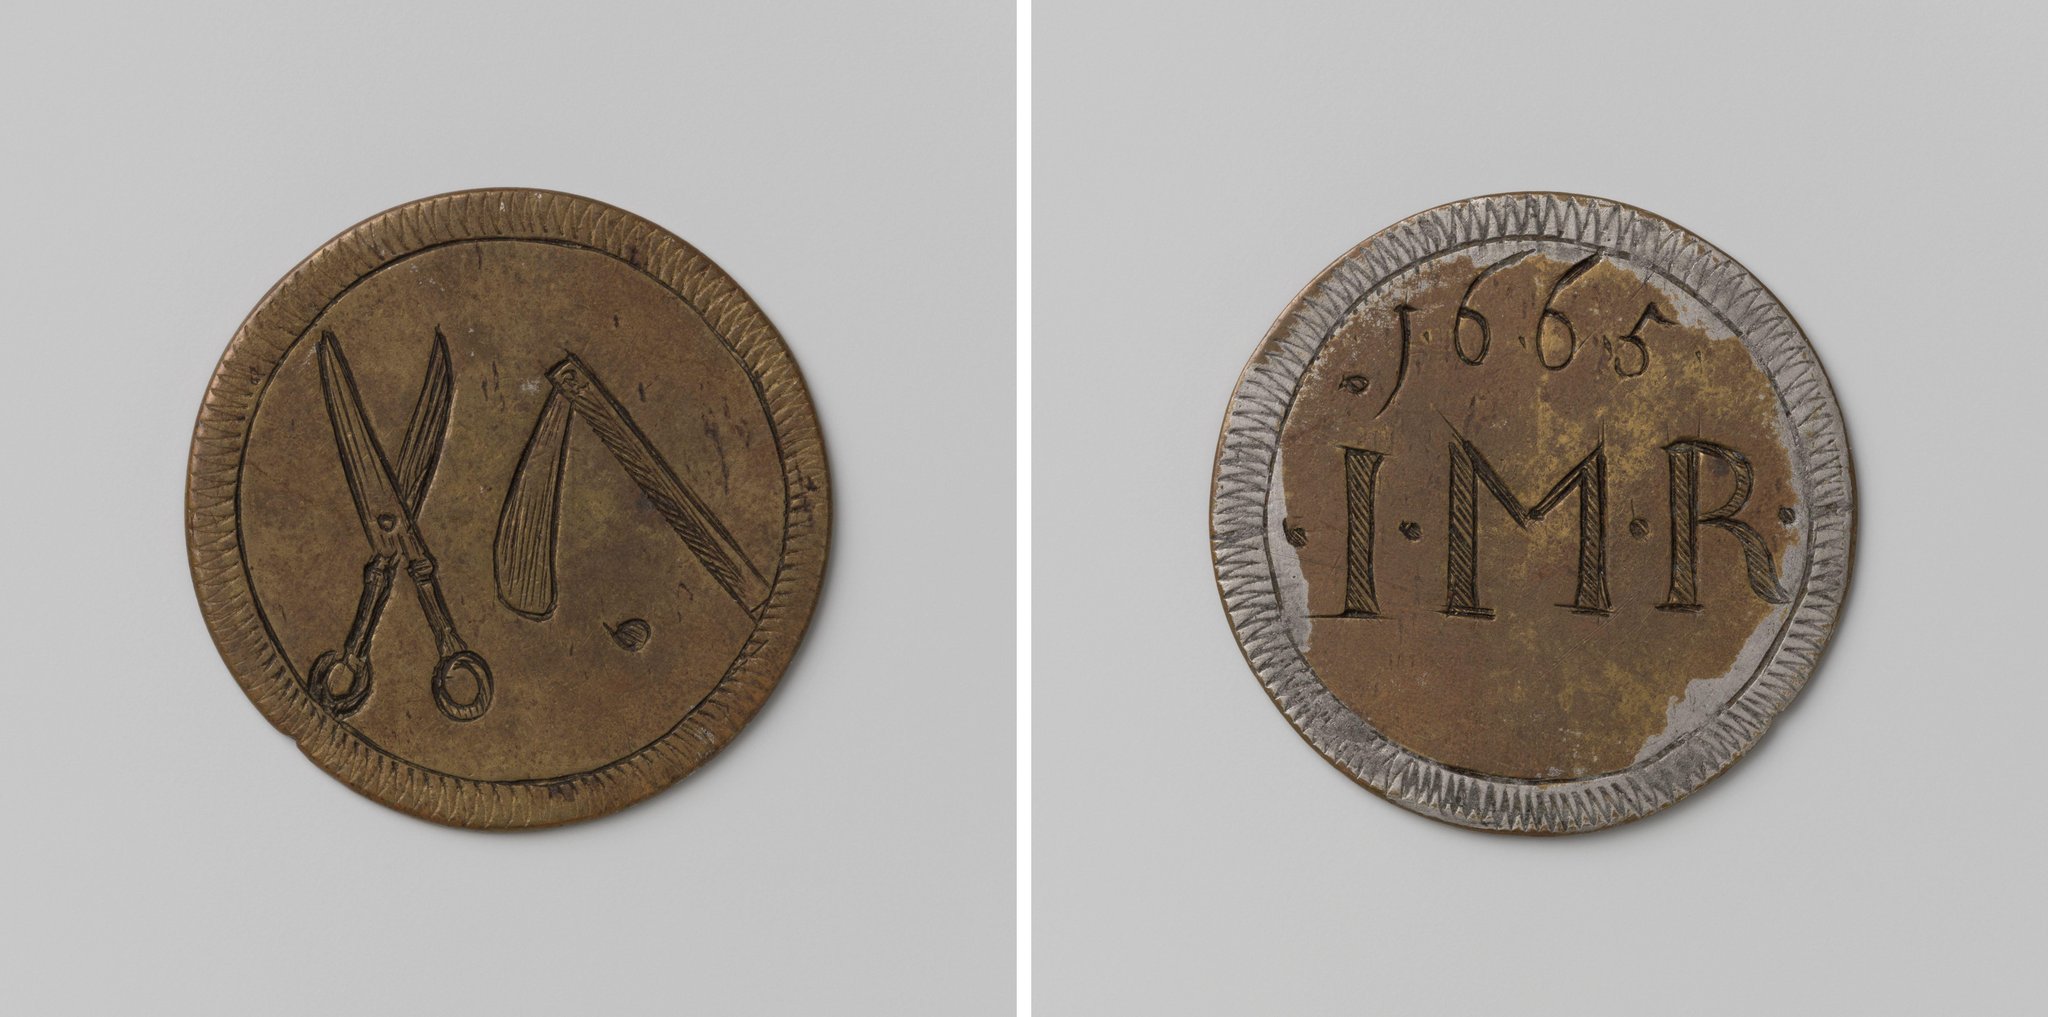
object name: medal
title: Barbiersgilde, gildepenning met monogram I.M.R.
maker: Anonymous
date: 1665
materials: brass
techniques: engraving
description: Messing penning. Voorzijde: geopende schaar en scheermes. Keerzijde: monogram van letters I, M en R boven jaartal.